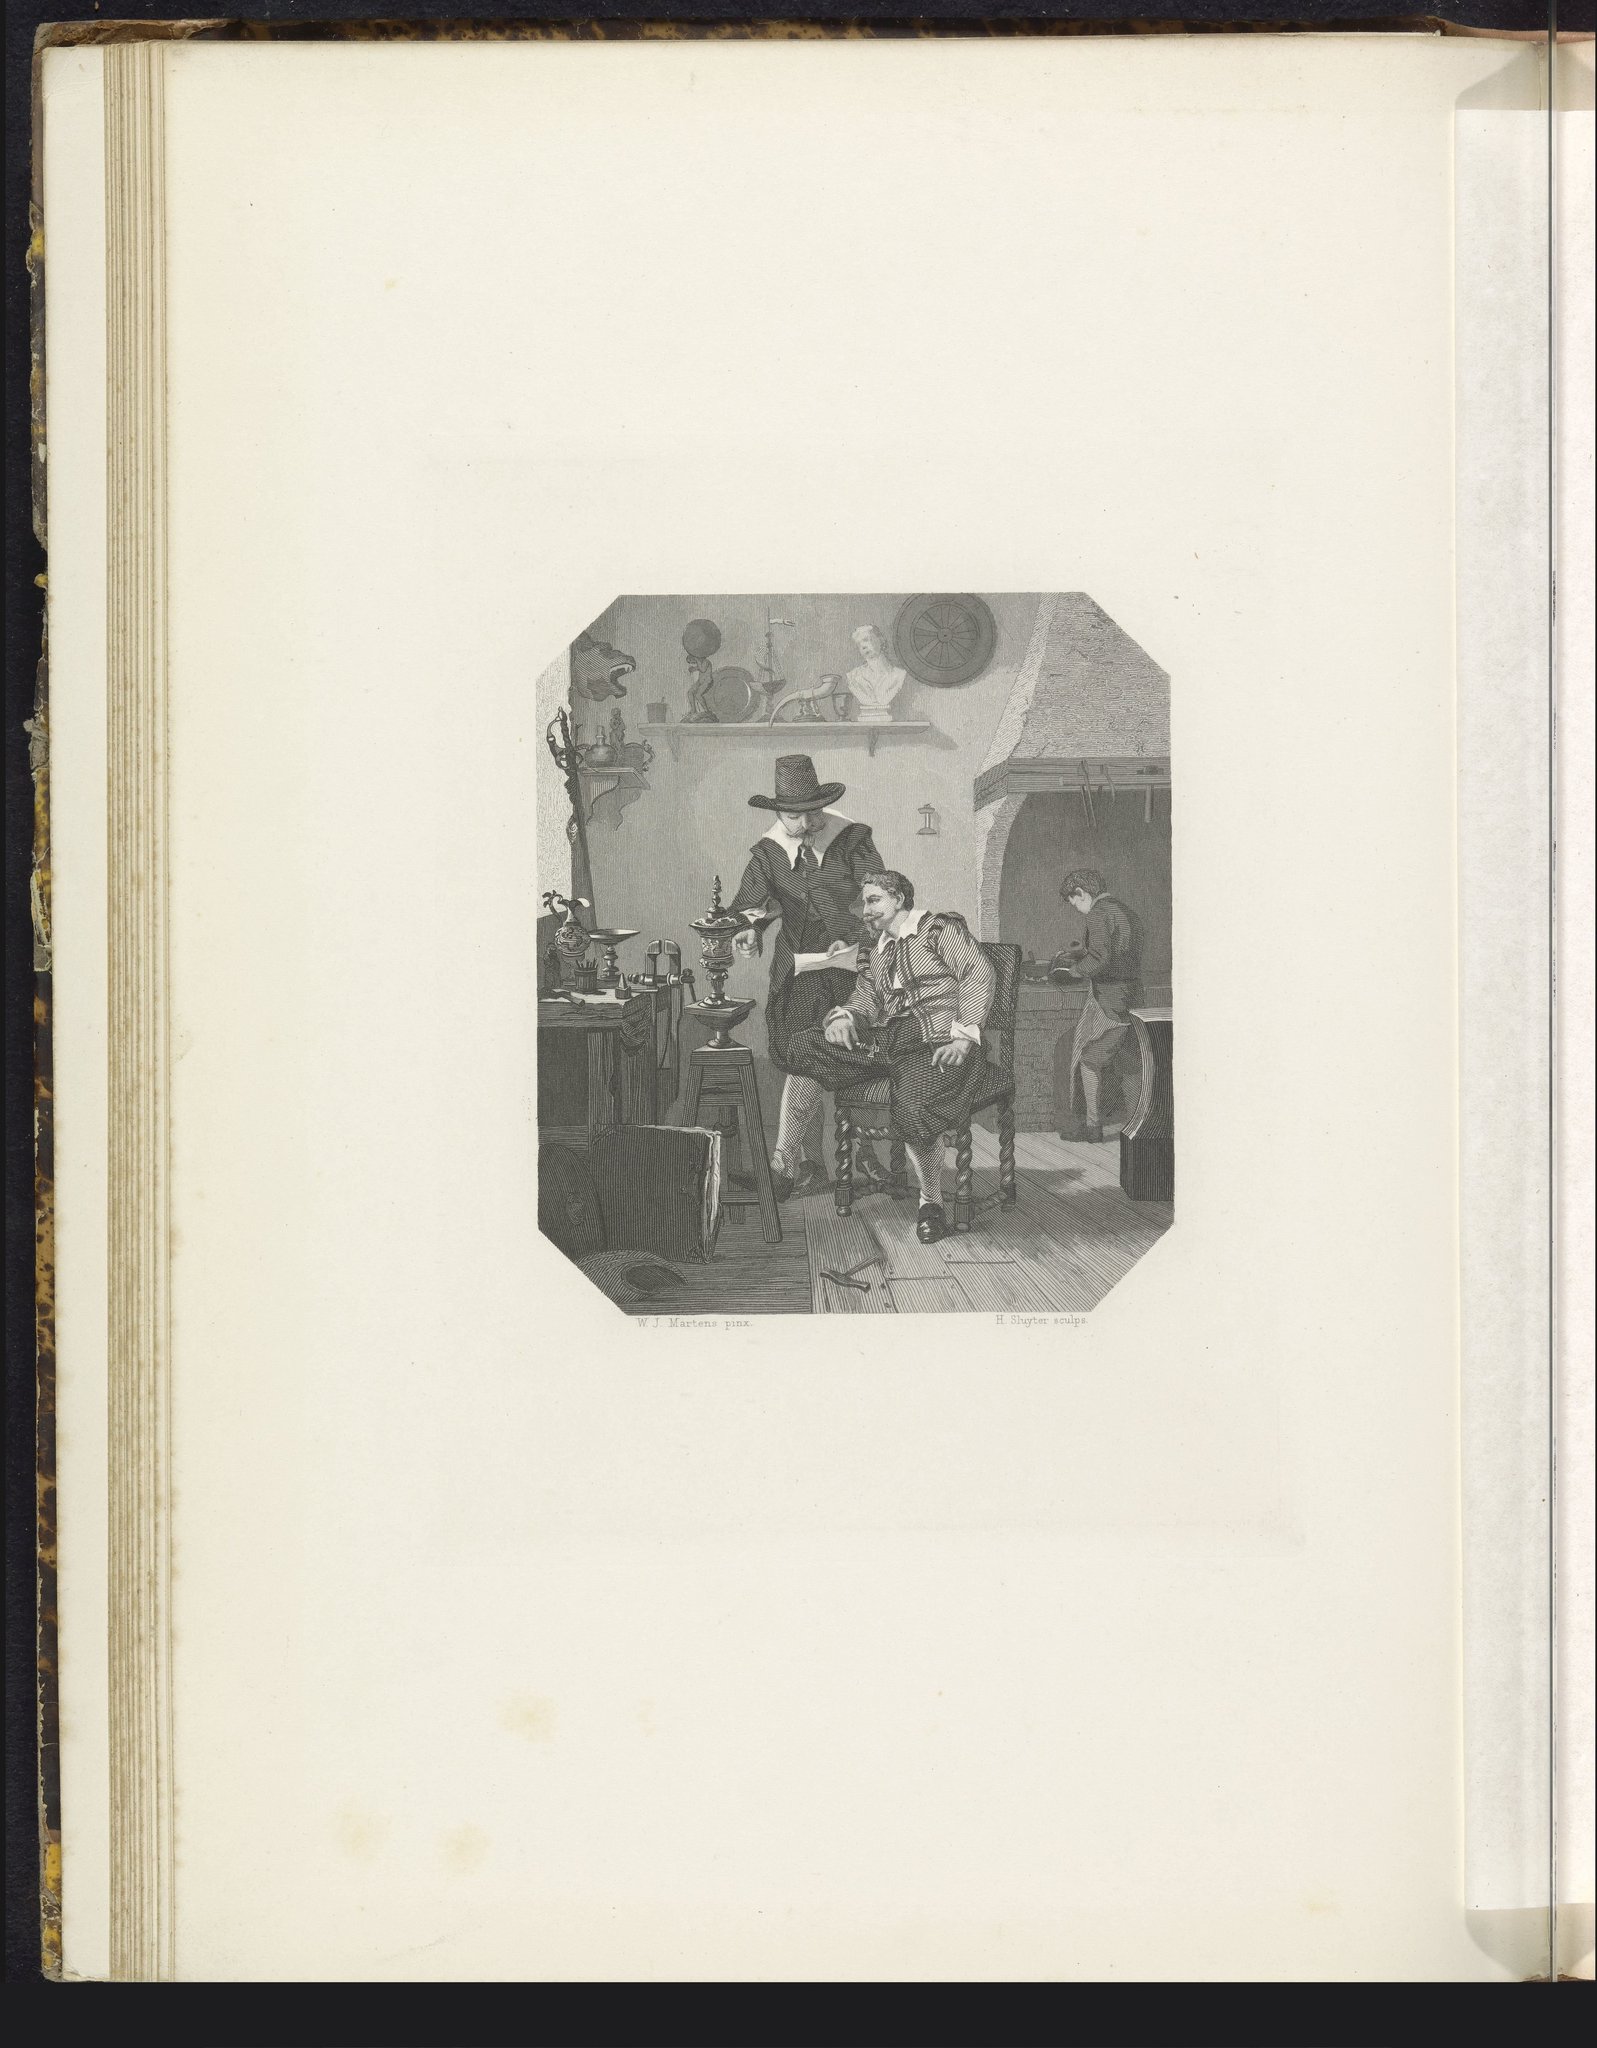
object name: print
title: De edelsmeden Adam van Vianen I en II, ca. 1616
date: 1865-1870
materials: paper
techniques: engraving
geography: netherlands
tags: utrecht, print maker, silversmith, adam van vianen (i), jeweler, jeweller, goldsmith, silversmith (+ artist at work)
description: De edelsmeden Adam van Vianen I en II in hun werkplaats, ca. 1616. Onderdeel van de groep staalgravures naar de schilderijen van de Historische Galerij der Maatschappij Arti et Amicitiae.